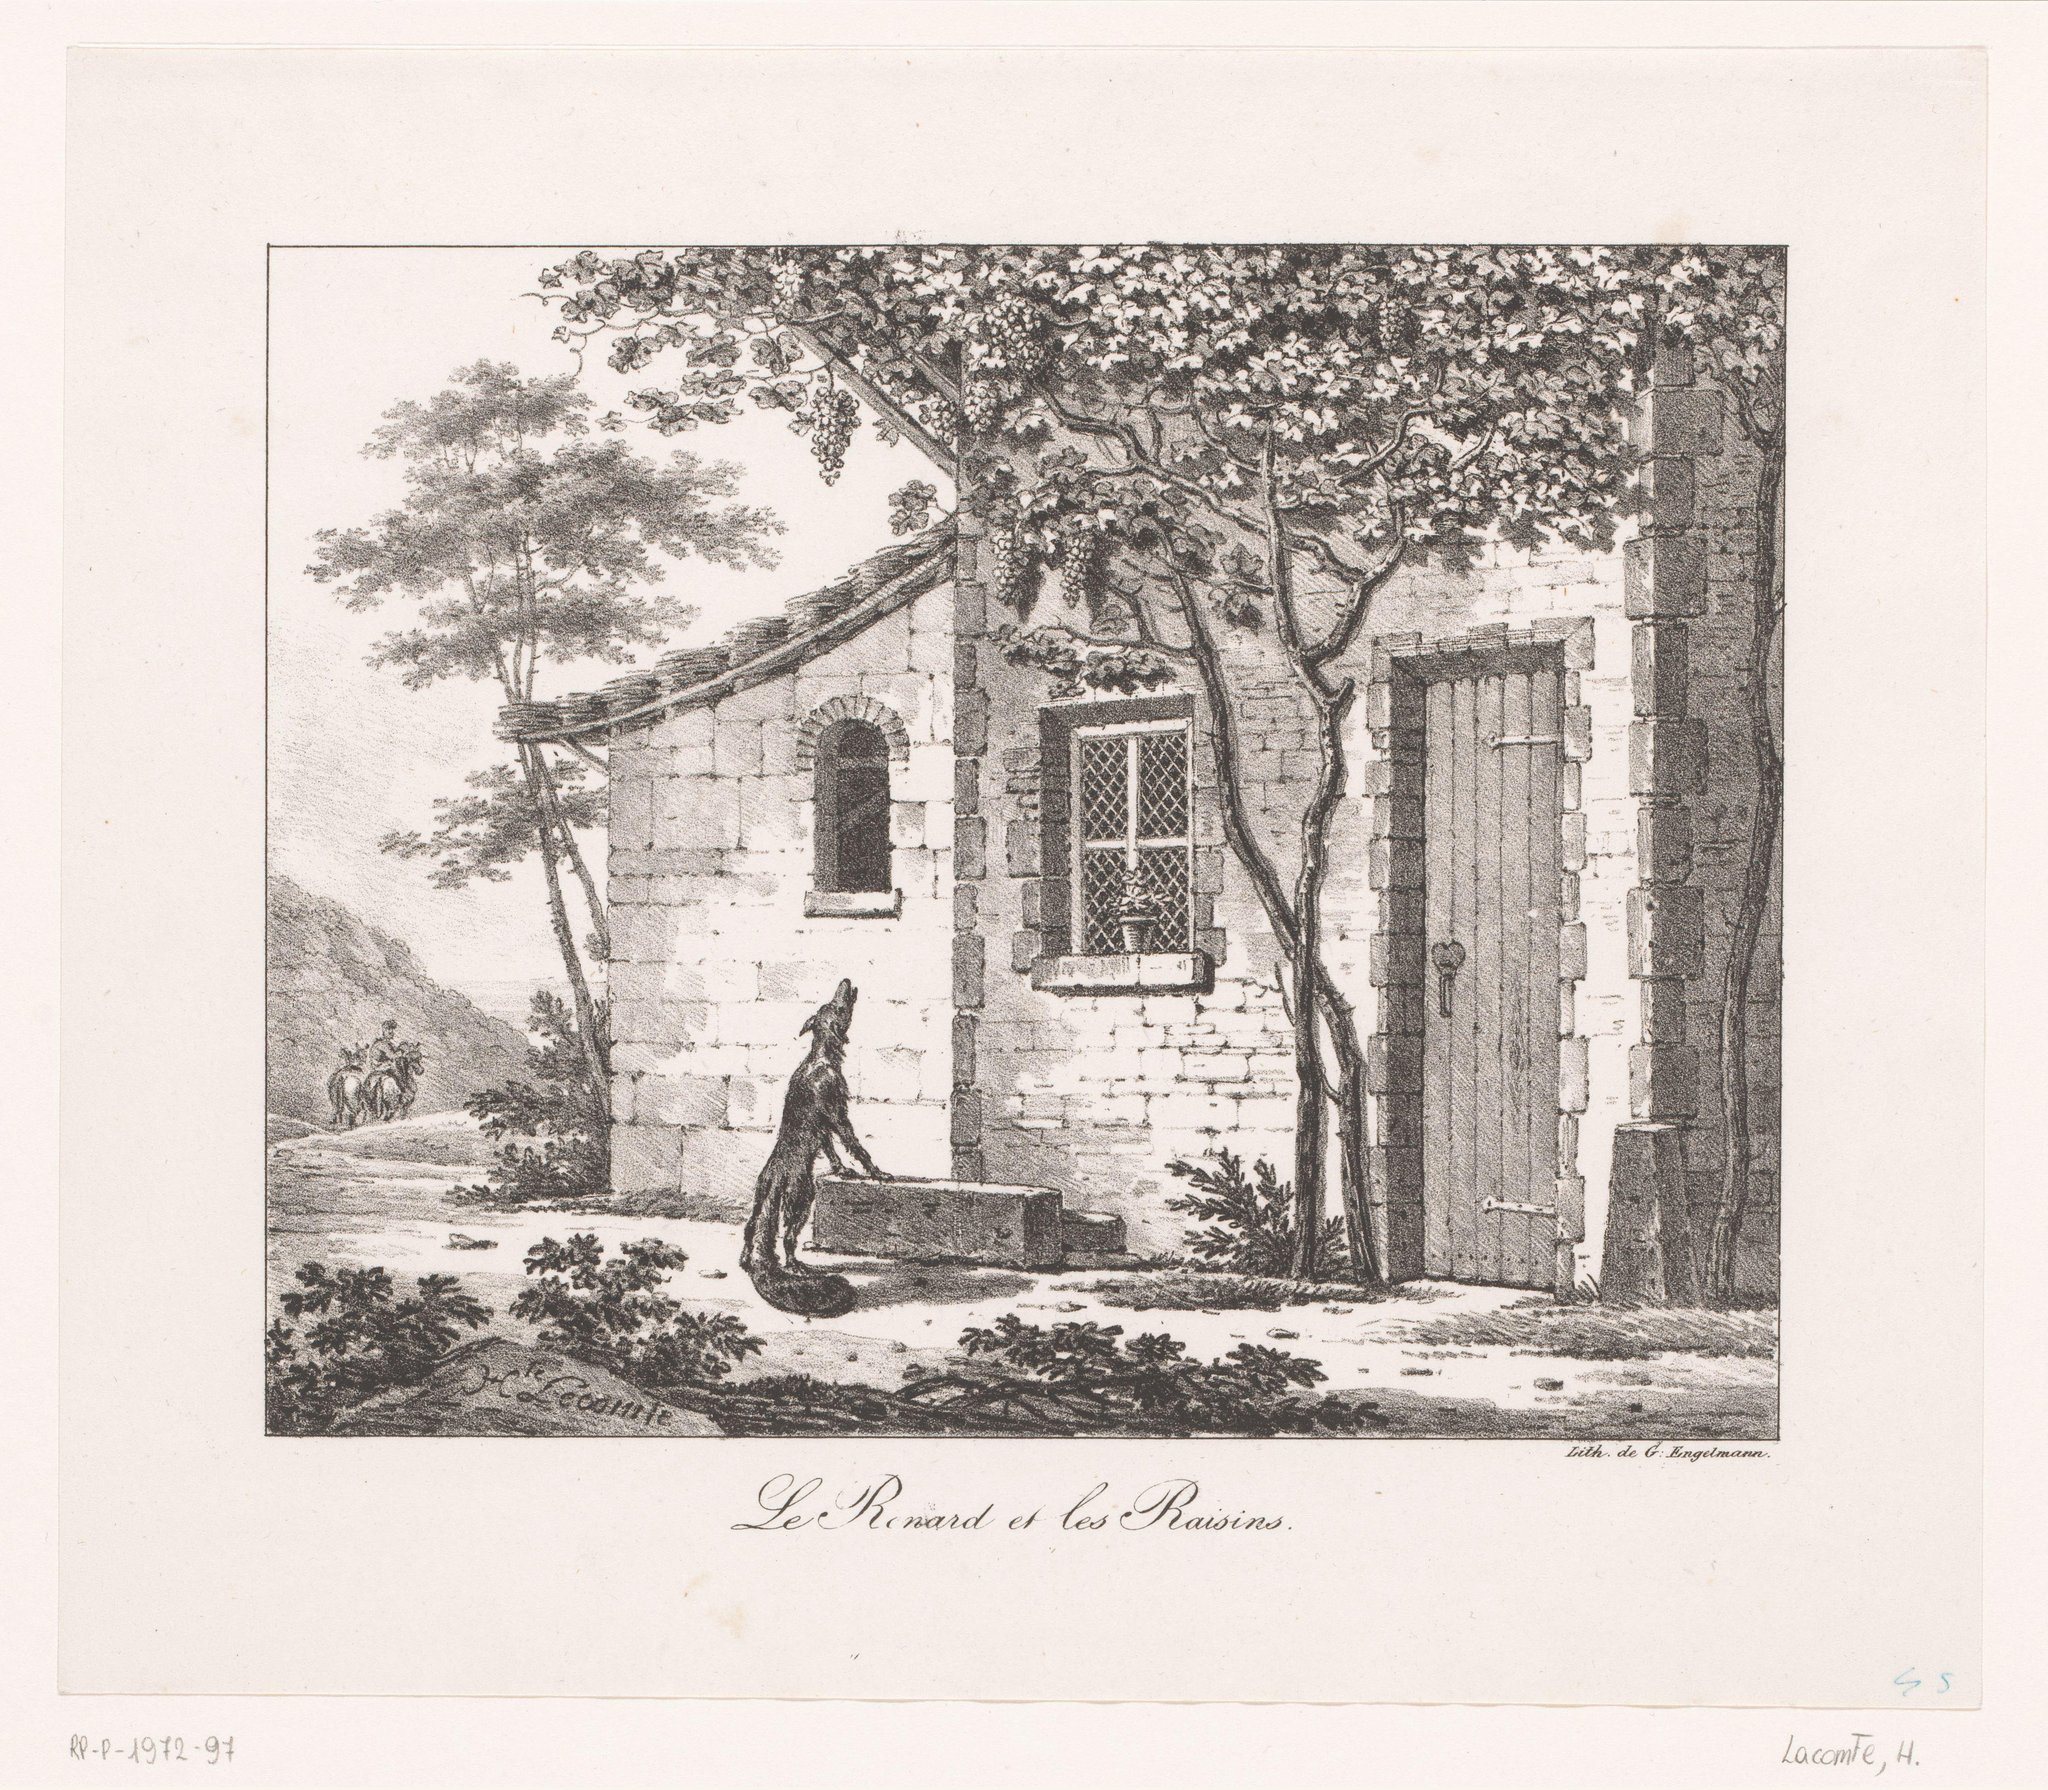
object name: print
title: Fables choisies de La Fontaine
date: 1818-1820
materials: paper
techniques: lithograph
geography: paris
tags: fables of lafontaine (with title) : use 85(...), bunch of grapes, beasts of prey, predatory animals: fox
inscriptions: collector's mark: Lugt 2228a, collector's mark: Lugt 2760